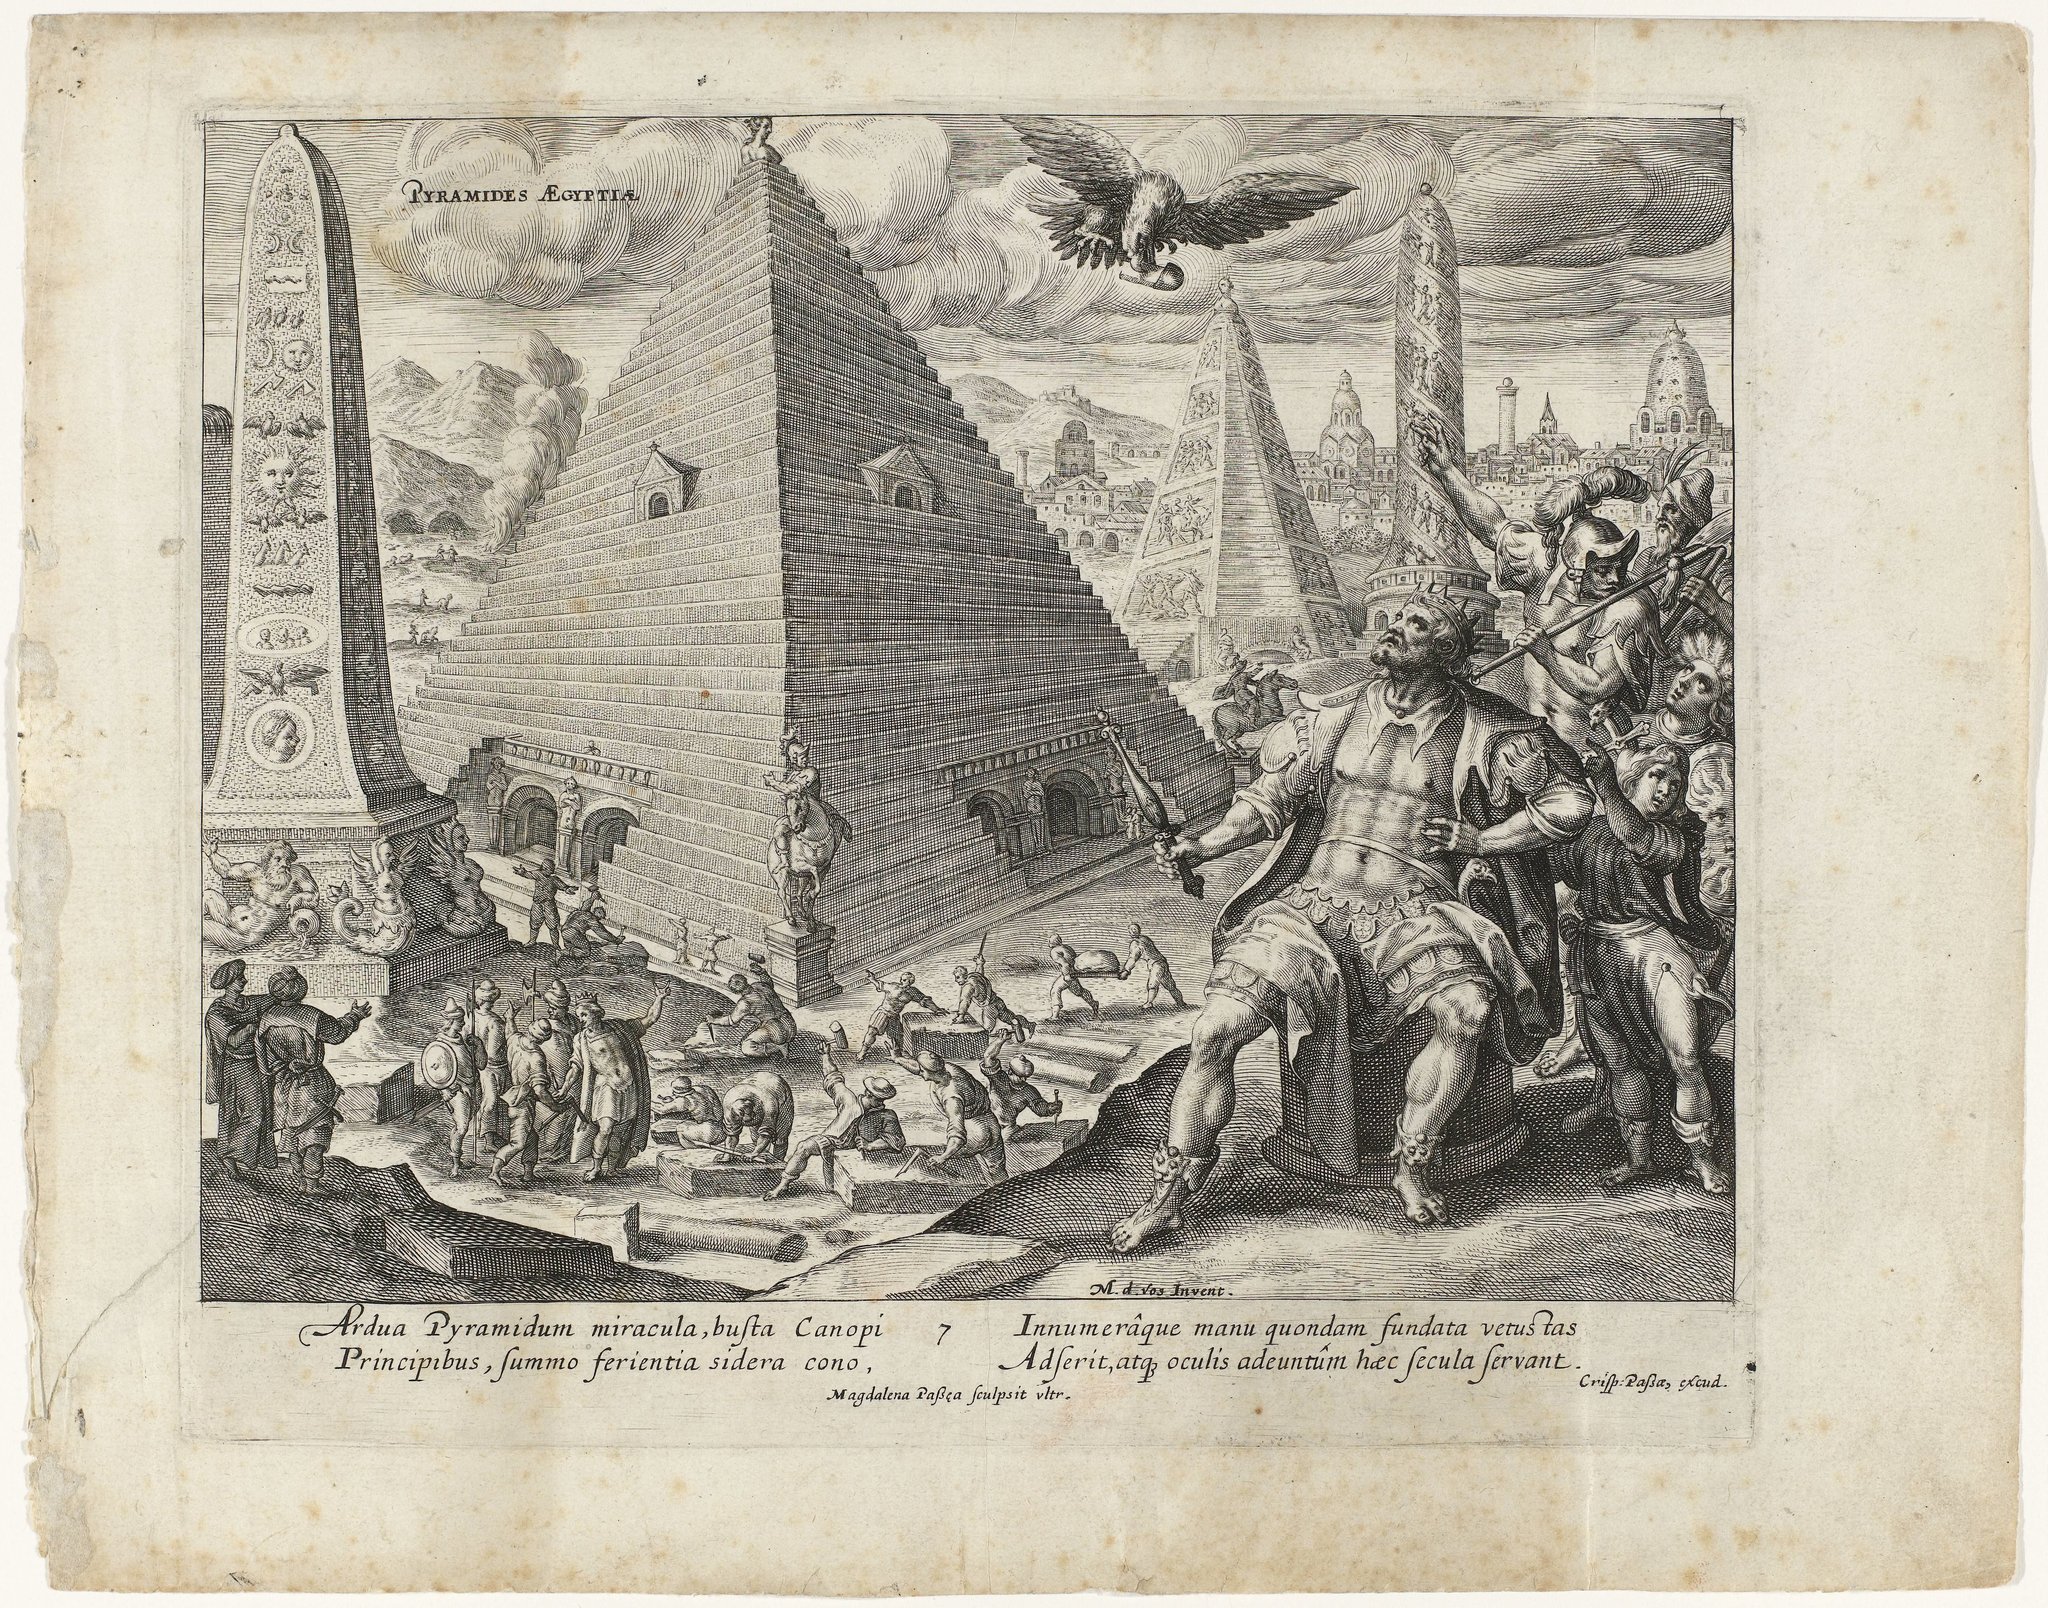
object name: print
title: De zeven wereldwonderen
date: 1614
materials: paper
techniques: engraving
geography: utrecht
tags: egyptian pyramids (wonder of the world), building-site